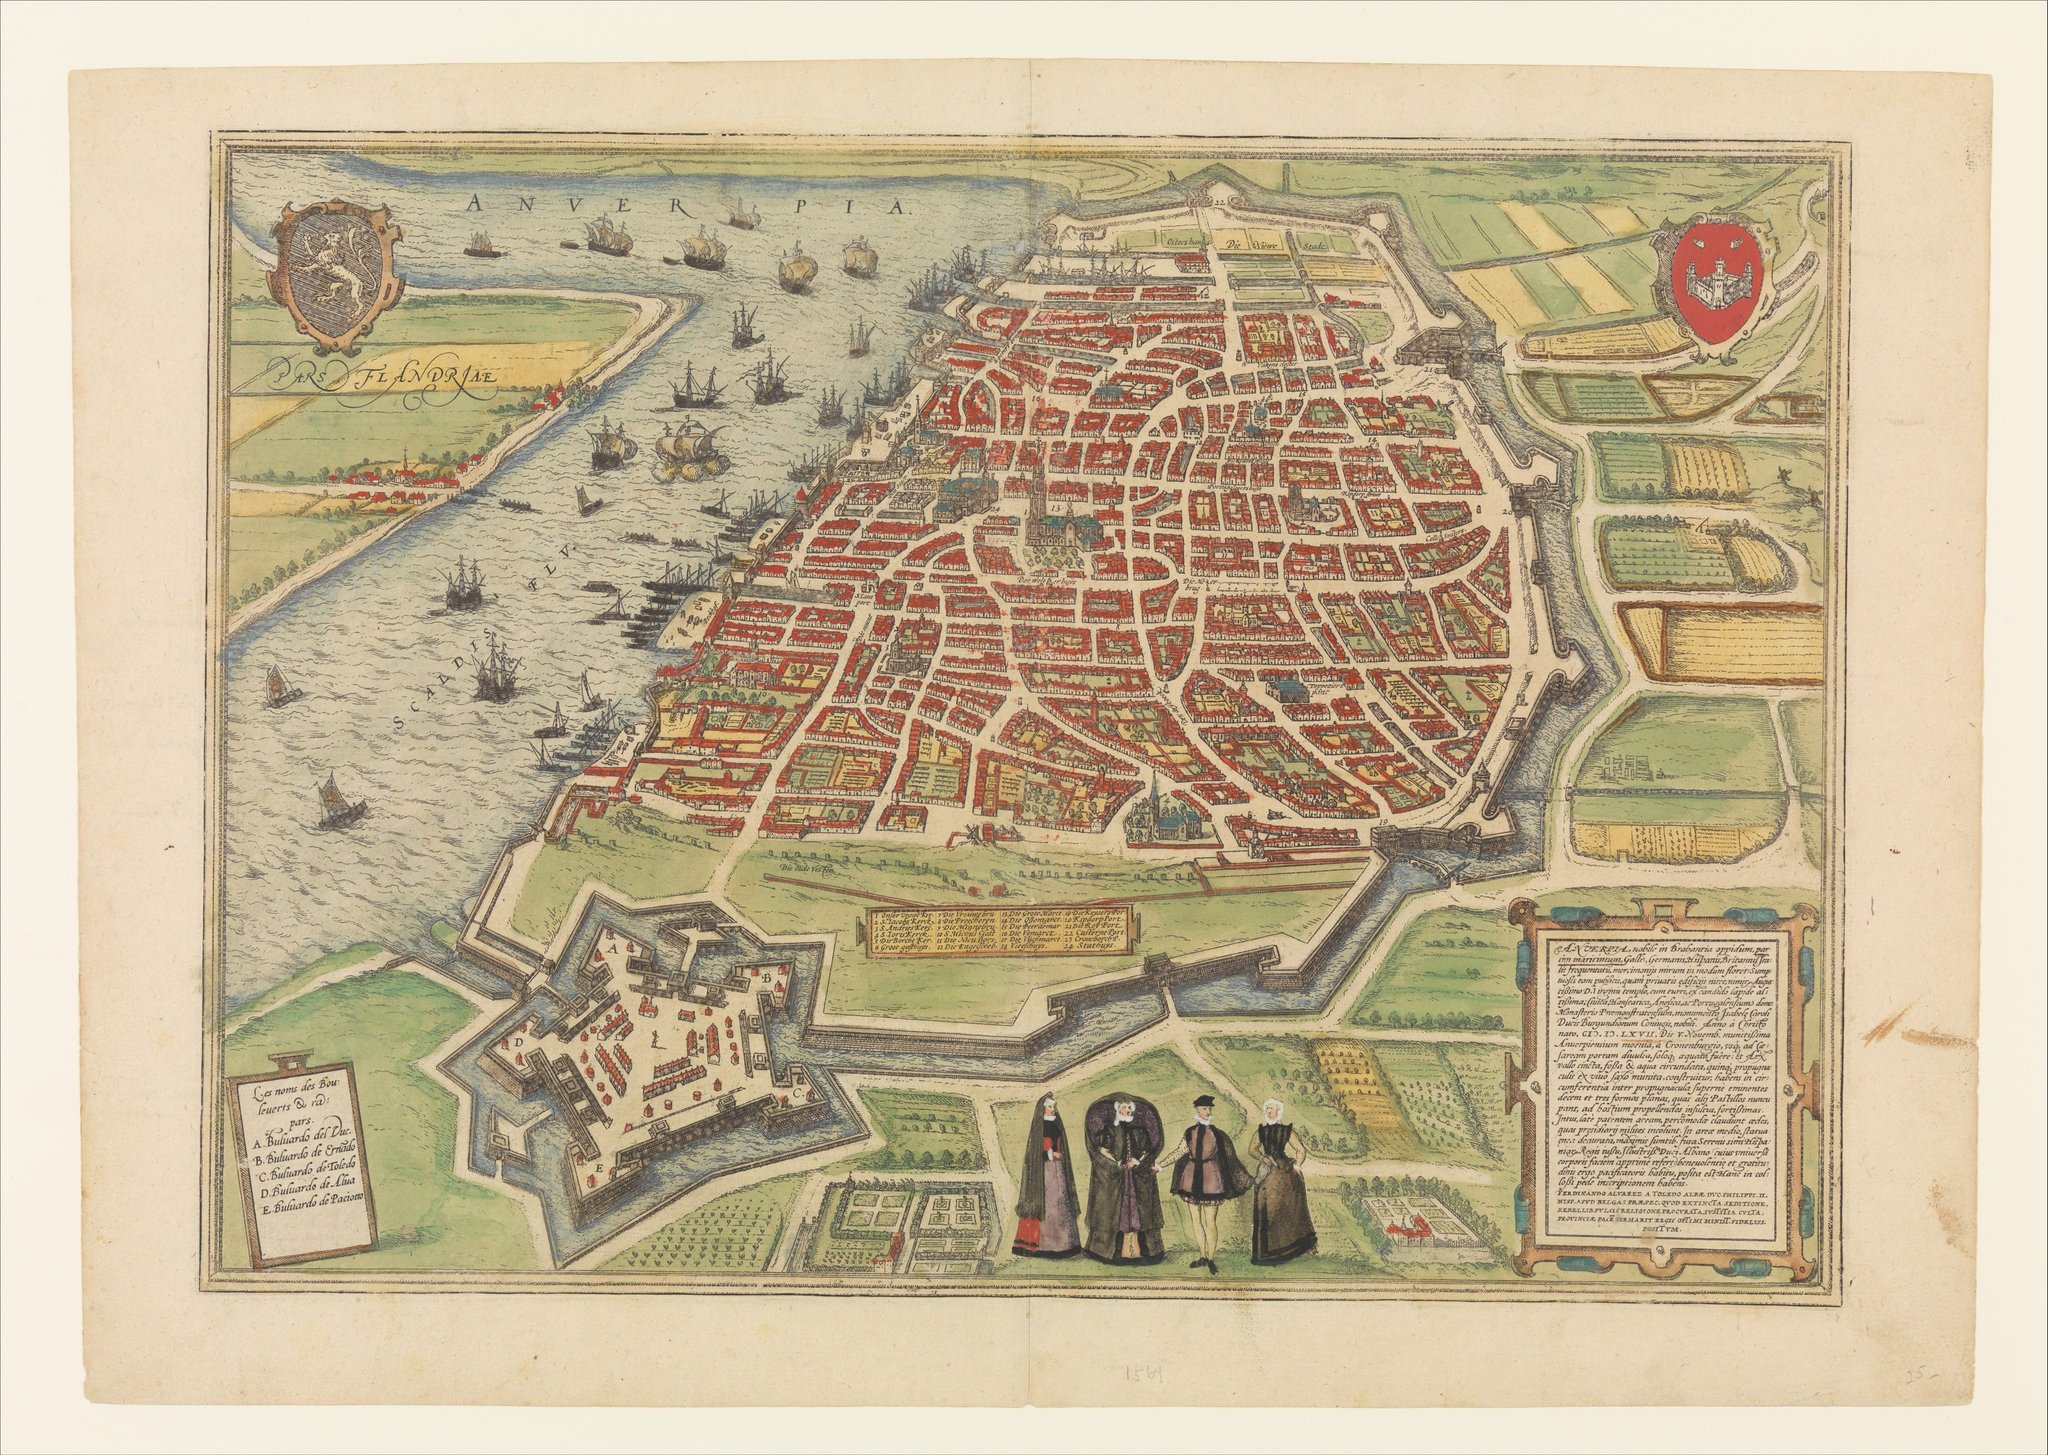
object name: print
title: View of Antwerp from Braun and Hogenberg's Civitates Orbis Terrarum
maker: joris hoefnagel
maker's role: artist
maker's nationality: netherlandish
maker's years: 1542-1600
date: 1572-1594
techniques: etching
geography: germany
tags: men,women,emblems,maps